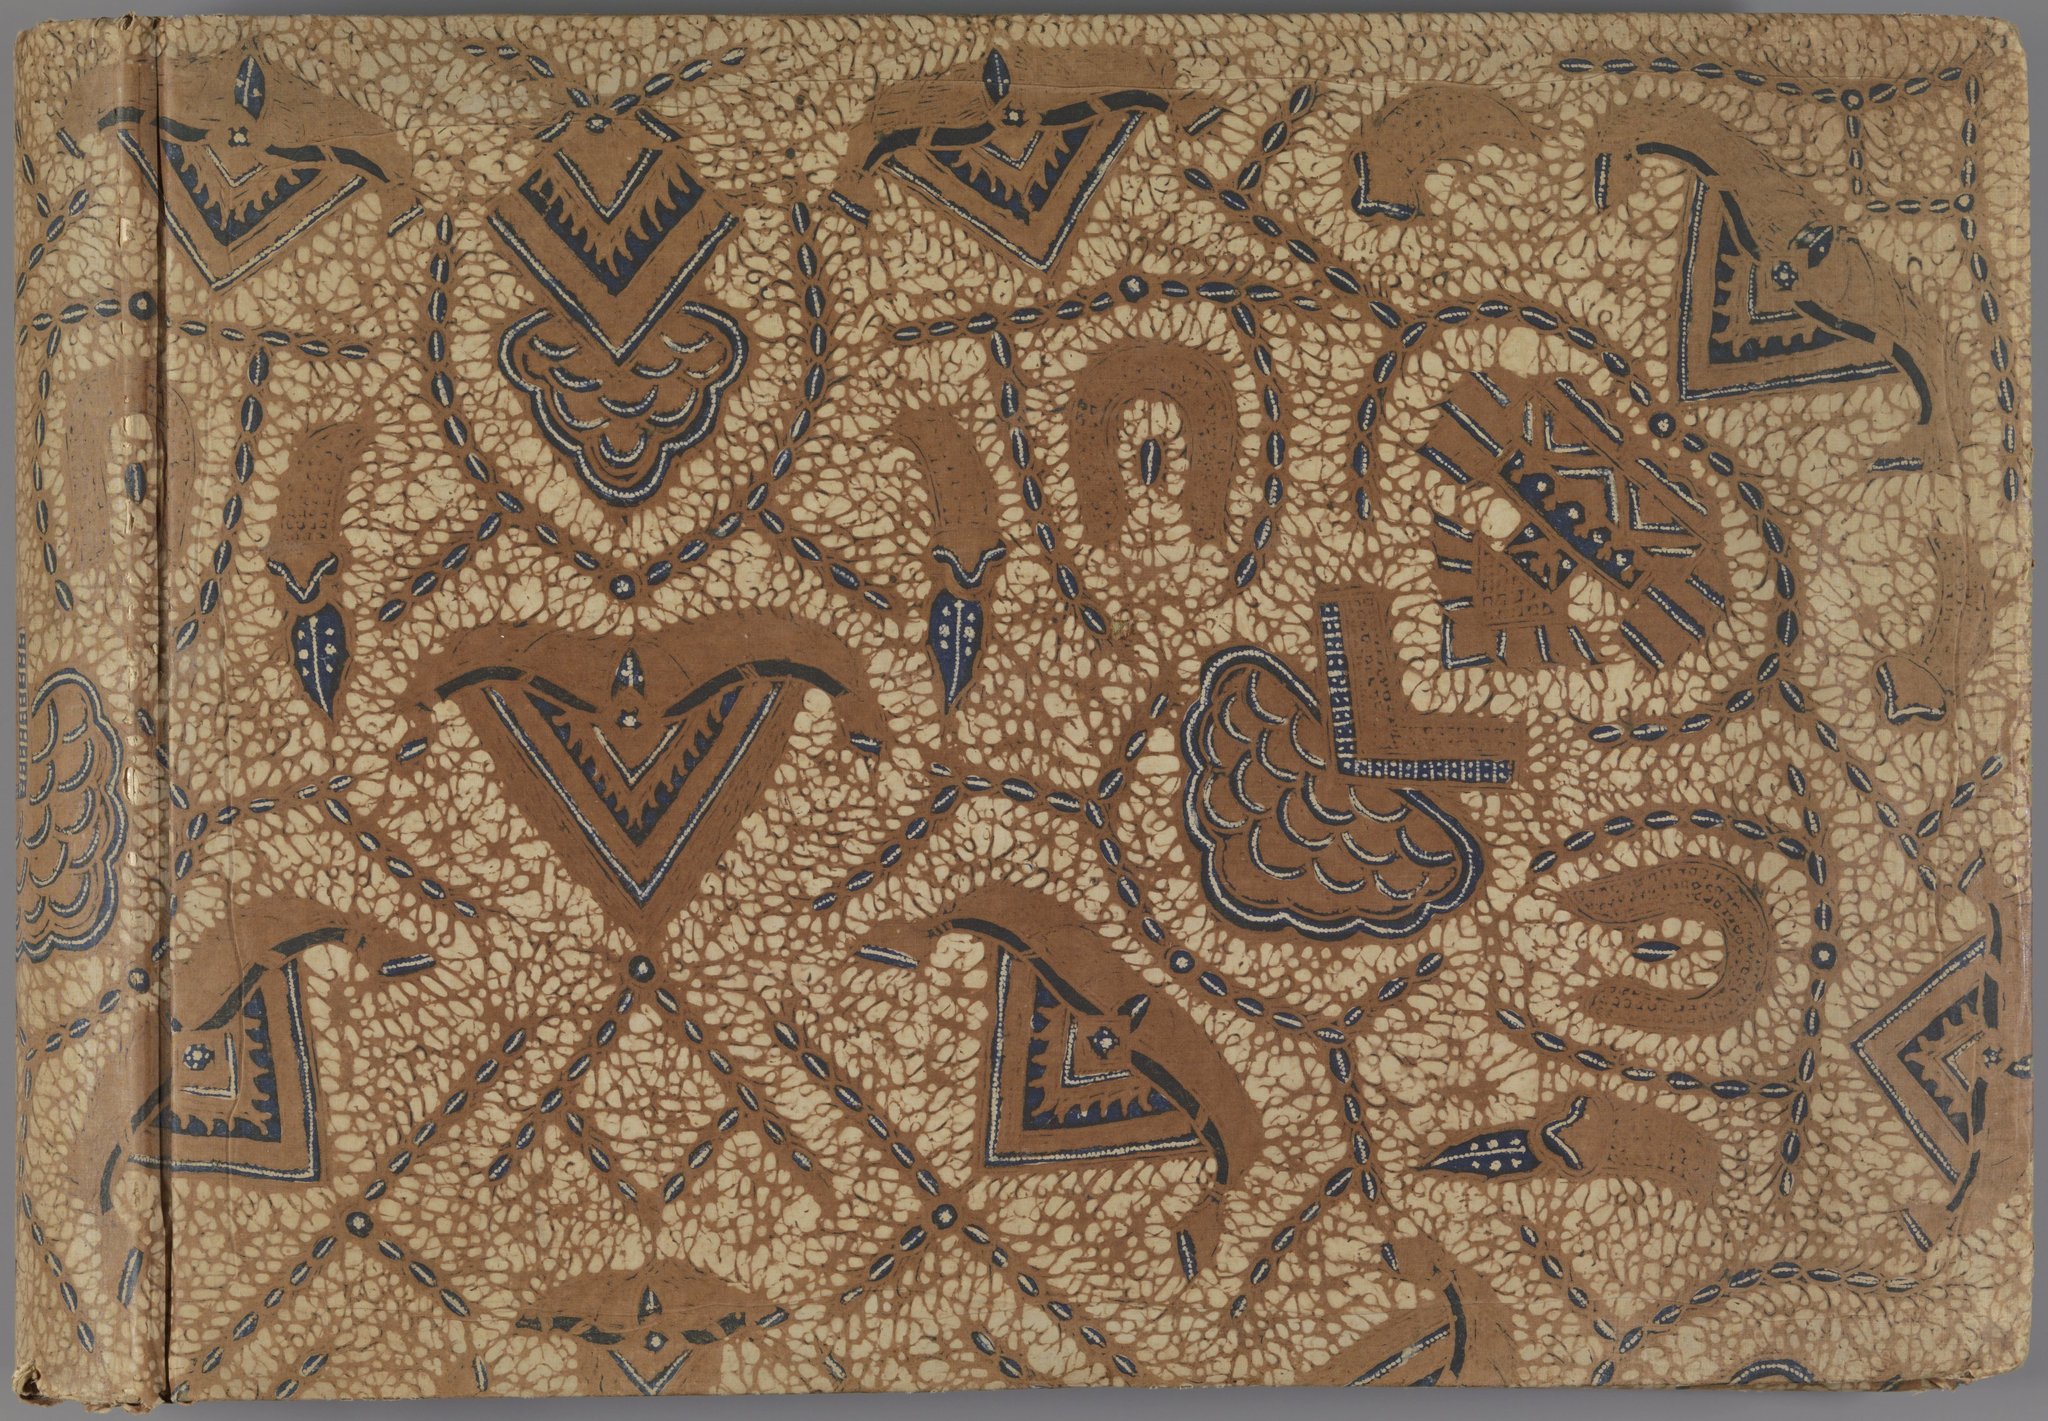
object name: photograph album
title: Reisalbum met foto's van bedrijvigheid en bezienswaardigheden op Sumatra en Java en van de reis naar en van Nederlands-Indië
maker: Anonymous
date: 1900-1920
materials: cardboard, paper, photographic support, textile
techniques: gelatin silver print, platinum process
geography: dutch east indies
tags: plantation, (non-fruit) products of plants or trees: rubber, oil; oil refinery, working class, labourers, travelling; tourism, tobacco, java, sumatra, dutch east indies, the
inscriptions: name: ‘Kantoorboekenfabriek Varekamp & Co. Medan Sumatra’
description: Fotoalbum in omslag van gebatikt doek. De schutbladen hebben een beige bladmotief. Het album bevat 100 albumbladen met 514 foto’s waaronder enkele panorama’s samengesteld van meerdere afdrukken. De meeste foto’s hebben een handgeschreven onderschrift. Het zijn opnames van de tabaks- en rubberteelt op plantages en van de oliewinning op Sumatra en Java: de velden, schuren, gebouwen, villa’s, tuinen en installaties. Ook Aziatische en Europese werknemers zijn afgebeeld. De laatste categorie wordt soms met namen aangeduid zoals ‘Henny’, ‘Leen’, ‘Kees’, ‘Chris’, ‘Roëll’, 'Poolman-Beyne', 'Jelgerhuis-Swildens', 'Van IJzeren', 'v.d. Sta[...]-Oostmeijer', ‘v. Zijp’, ‘Kroese’, ‘Herman’ en ‘Heinecken’. Daarnaast worden bezienswaardigheden in steden en op het platteland in beeld gebracht waaronder bergen, vulkanen, baaien, sawa’s, parken, tempels, hotels, winkels, straten, spoorwegen en bruggen. Ook de zeereis naar en van Nederlands-Indië via het Suezkanaal komt aan de orde.